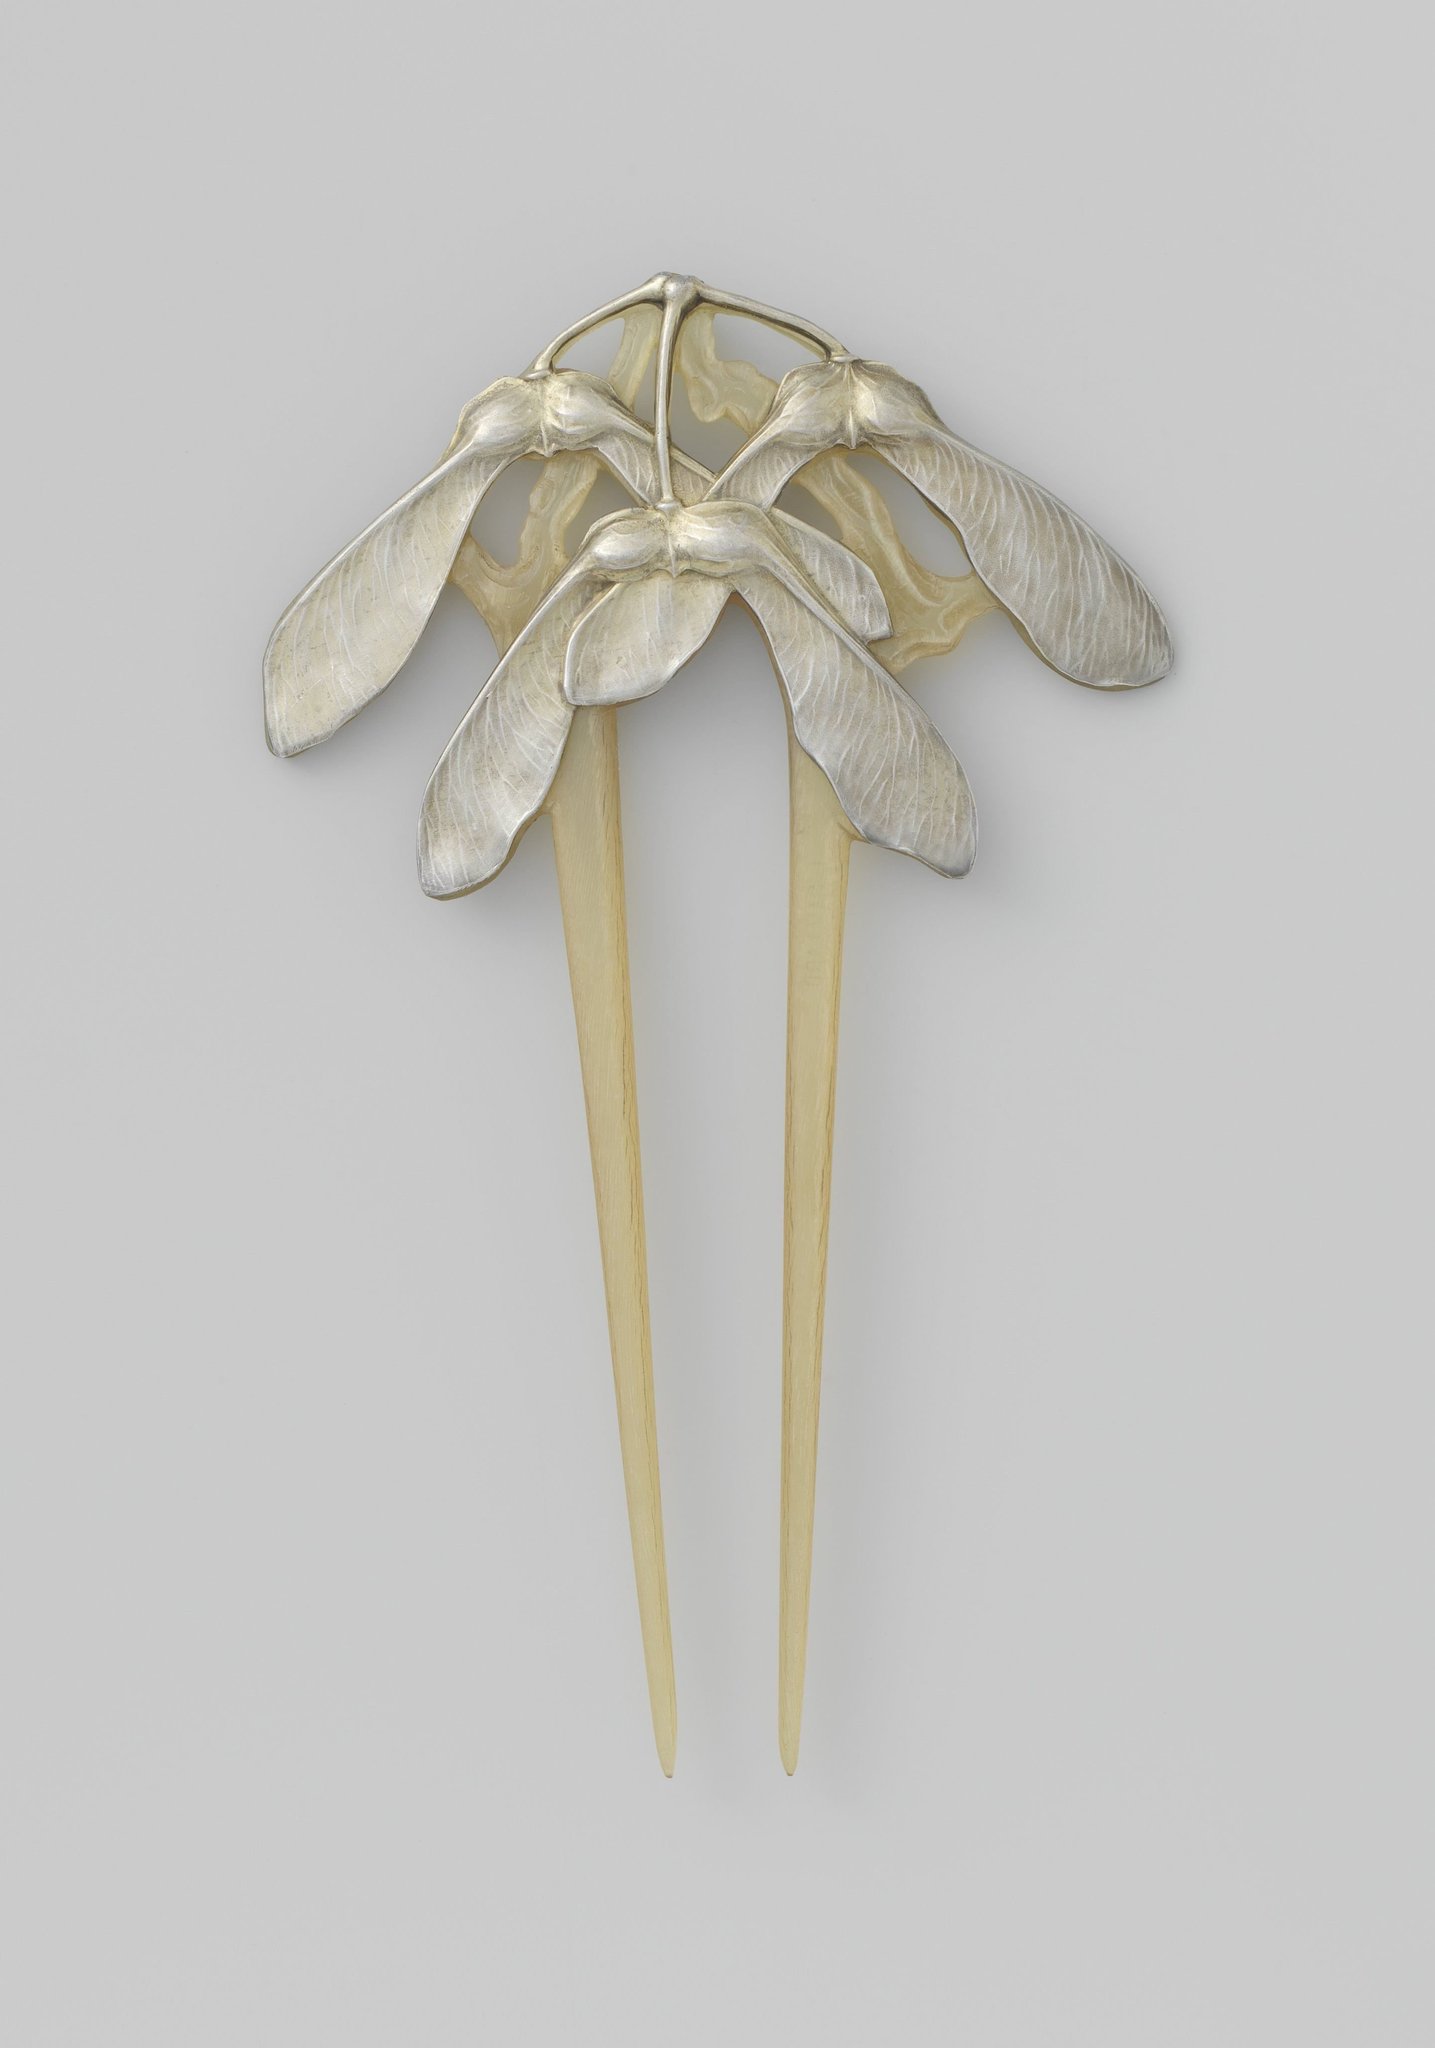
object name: jewellery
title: Hair Comb with Maple Seed Pods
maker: lucien gaillard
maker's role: jeweler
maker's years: 1861-1942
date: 1902-1906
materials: horn, silver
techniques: forging, gilding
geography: paris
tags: trees: maple (+ parts of plants)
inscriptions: mark: ‘L. GAILLARD’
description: Comb. Horn and silver. Paris, c. 1902 - 1906, by Lucien Gaillard.